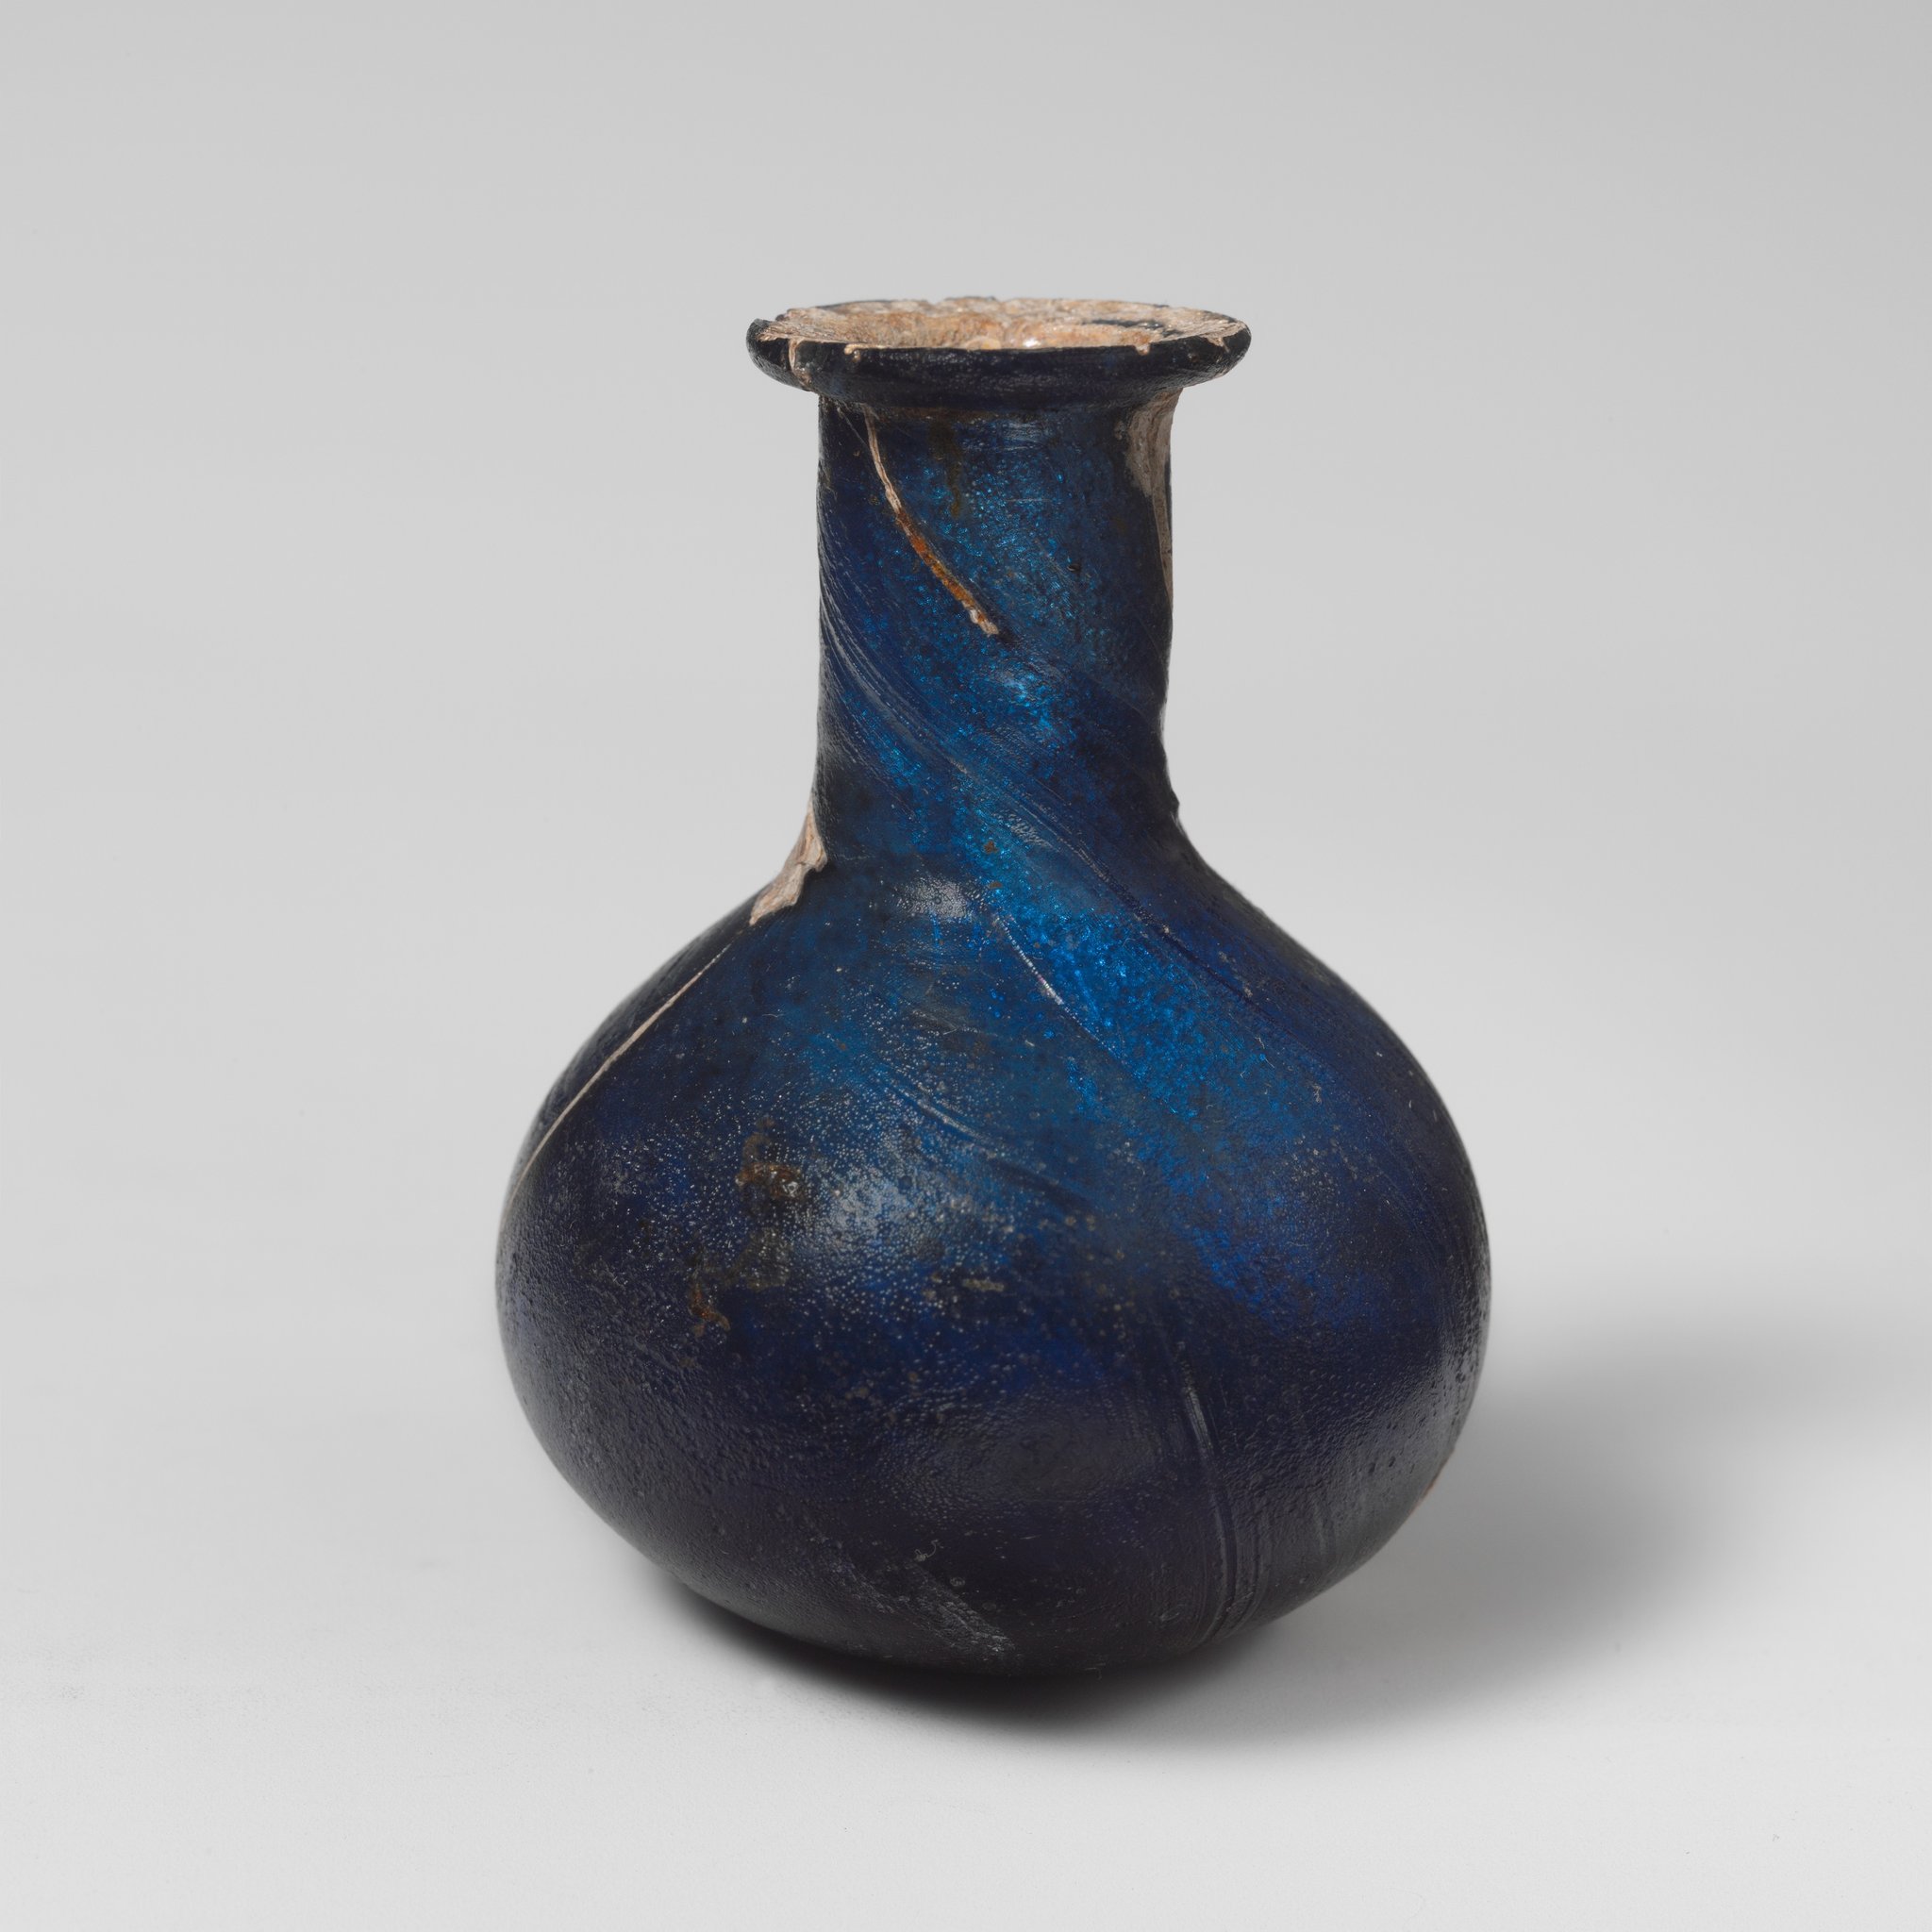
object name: perfume bottle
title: Glass perfume bottle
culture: roman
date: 1-100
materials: glass